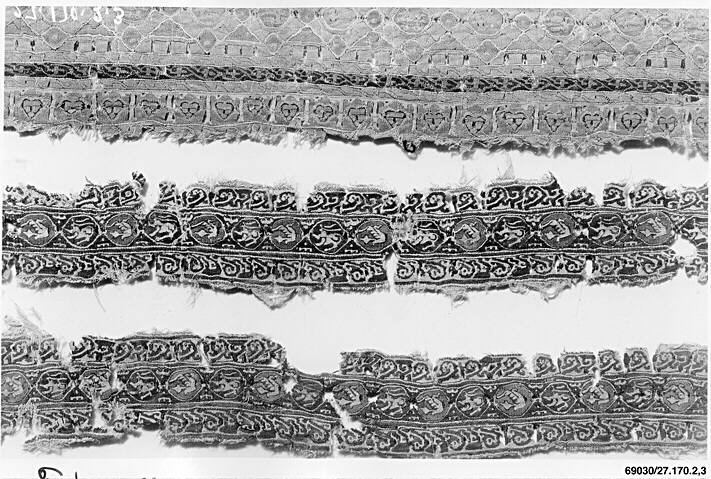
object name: band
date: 1101-1200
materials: linen, silk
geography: egypt